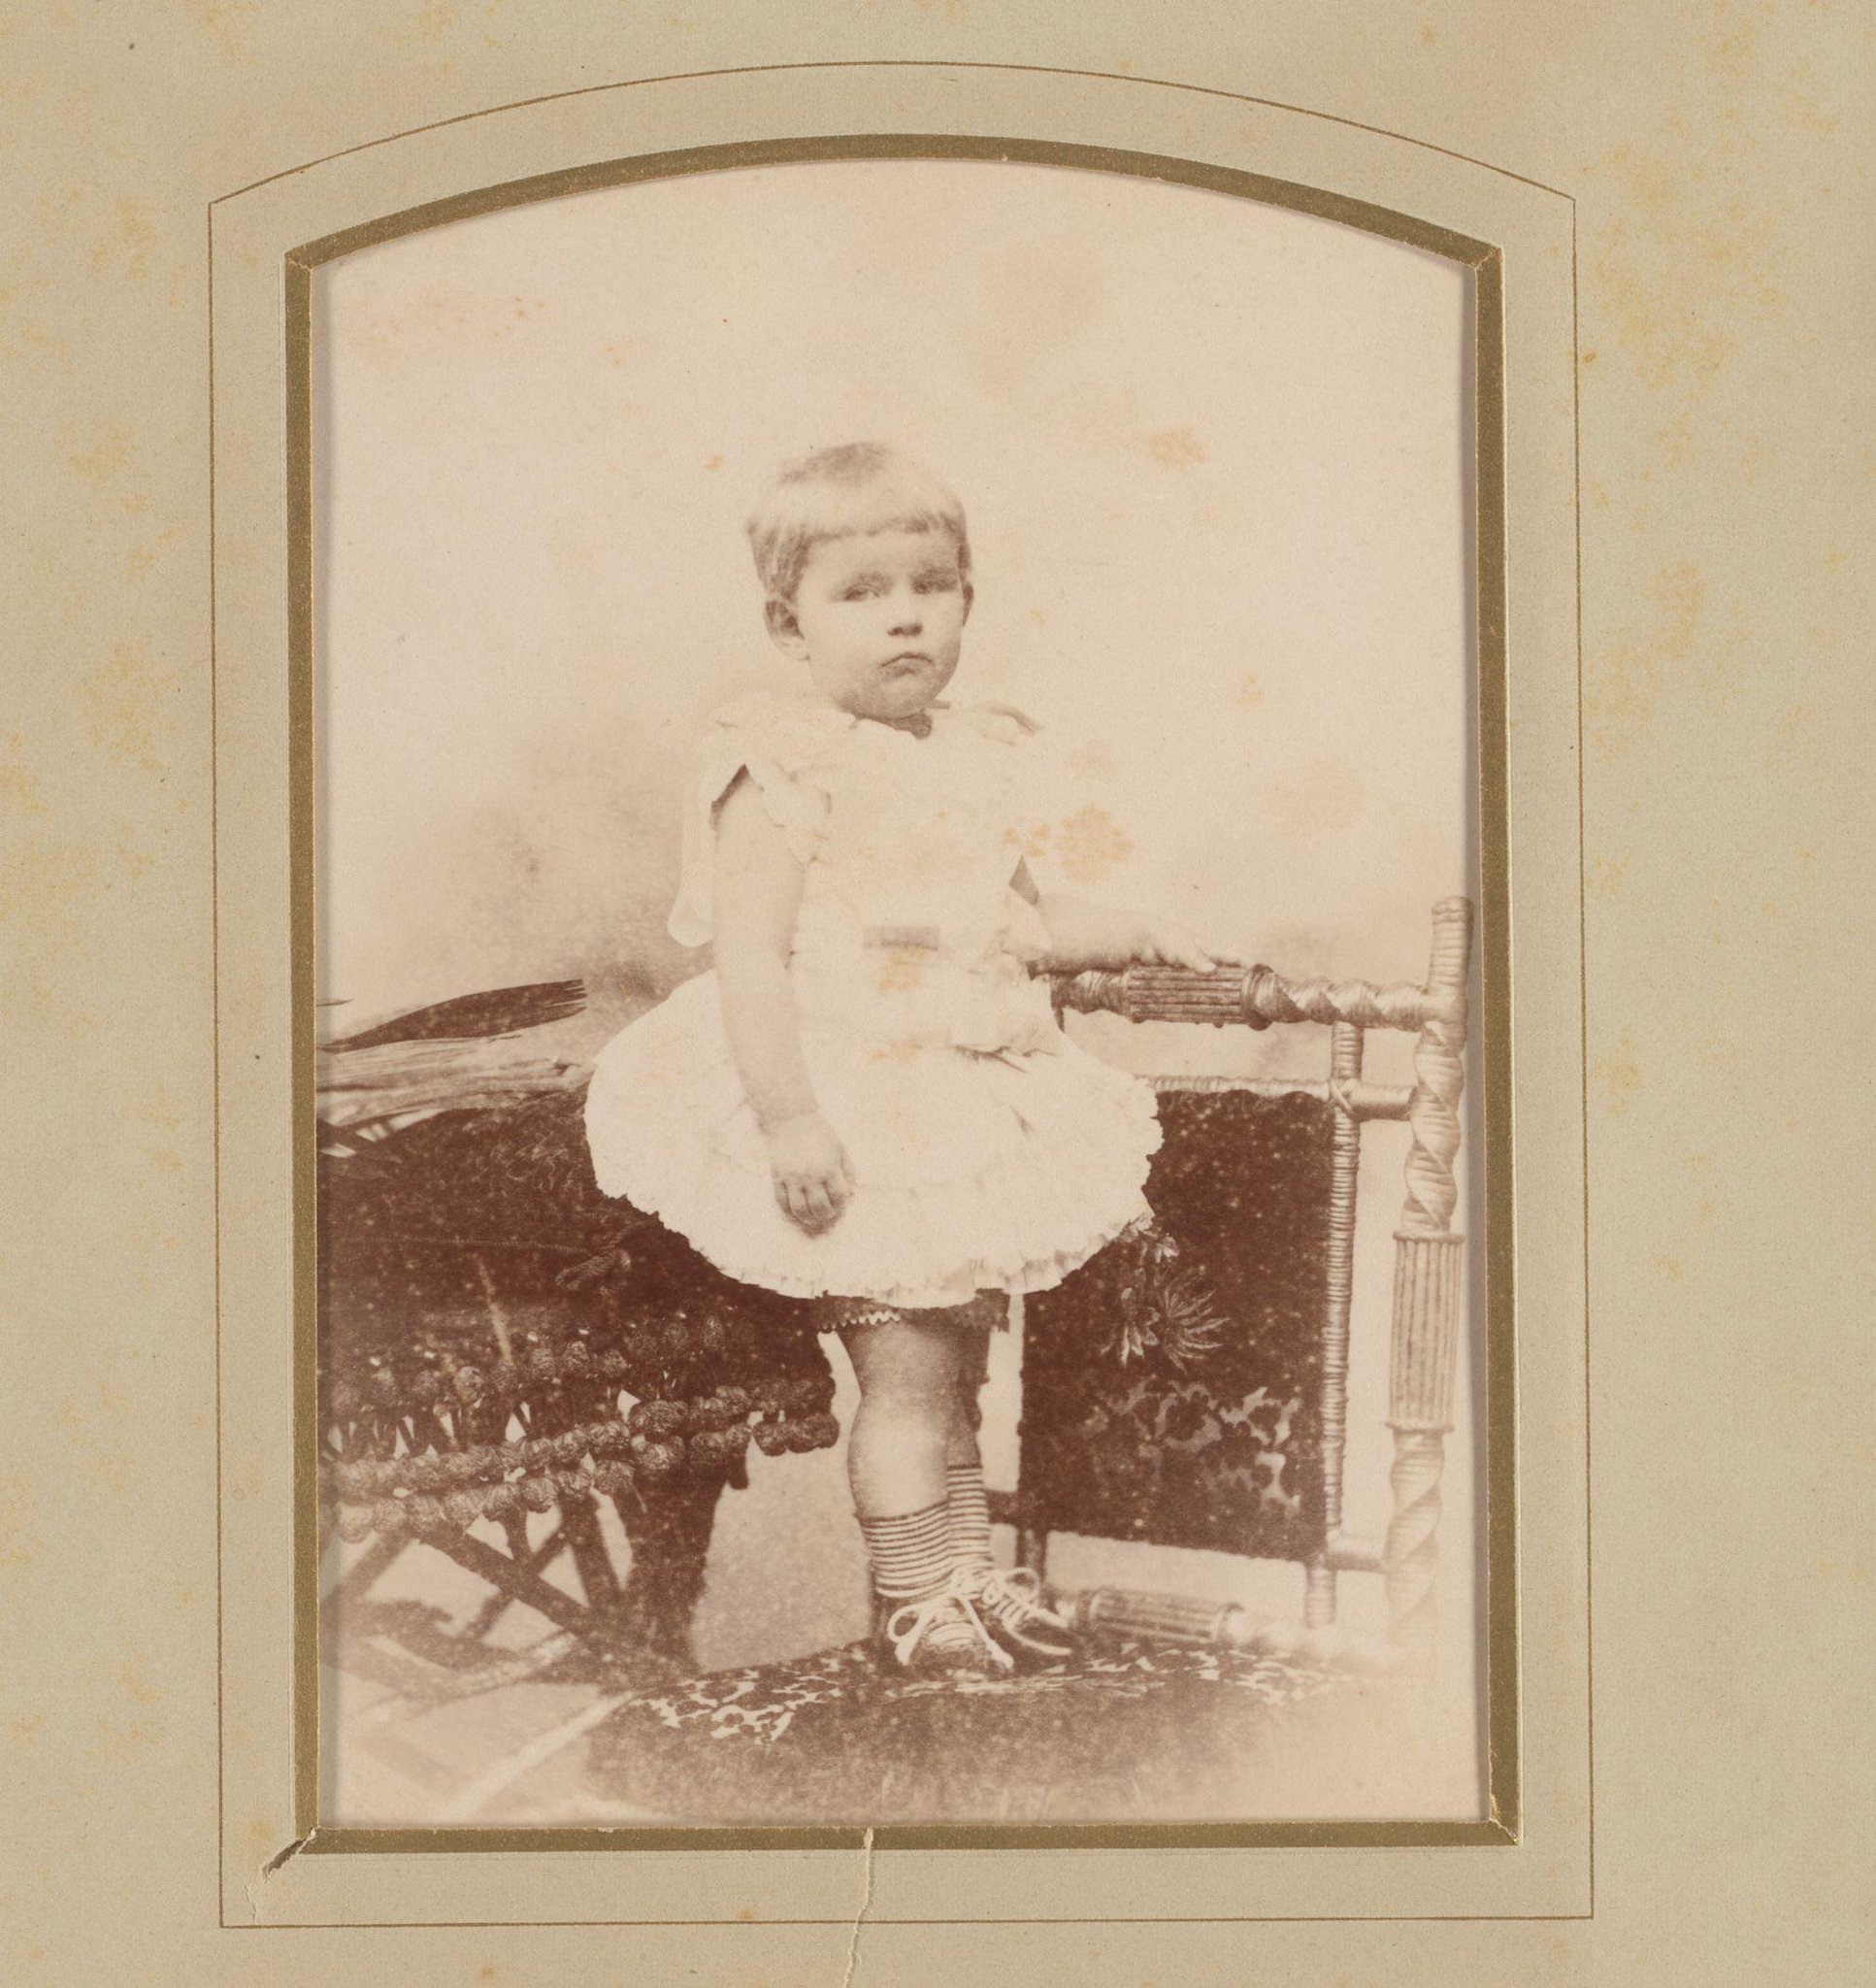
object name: photograph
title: Portret van An Kessler op een stoel op ongeveer 2 jarige leeftijd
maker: kameke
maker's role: painter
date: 1880-1920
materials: paper, photographic support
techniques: photography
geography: the hague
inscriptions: inscription: ‘An Kessler’